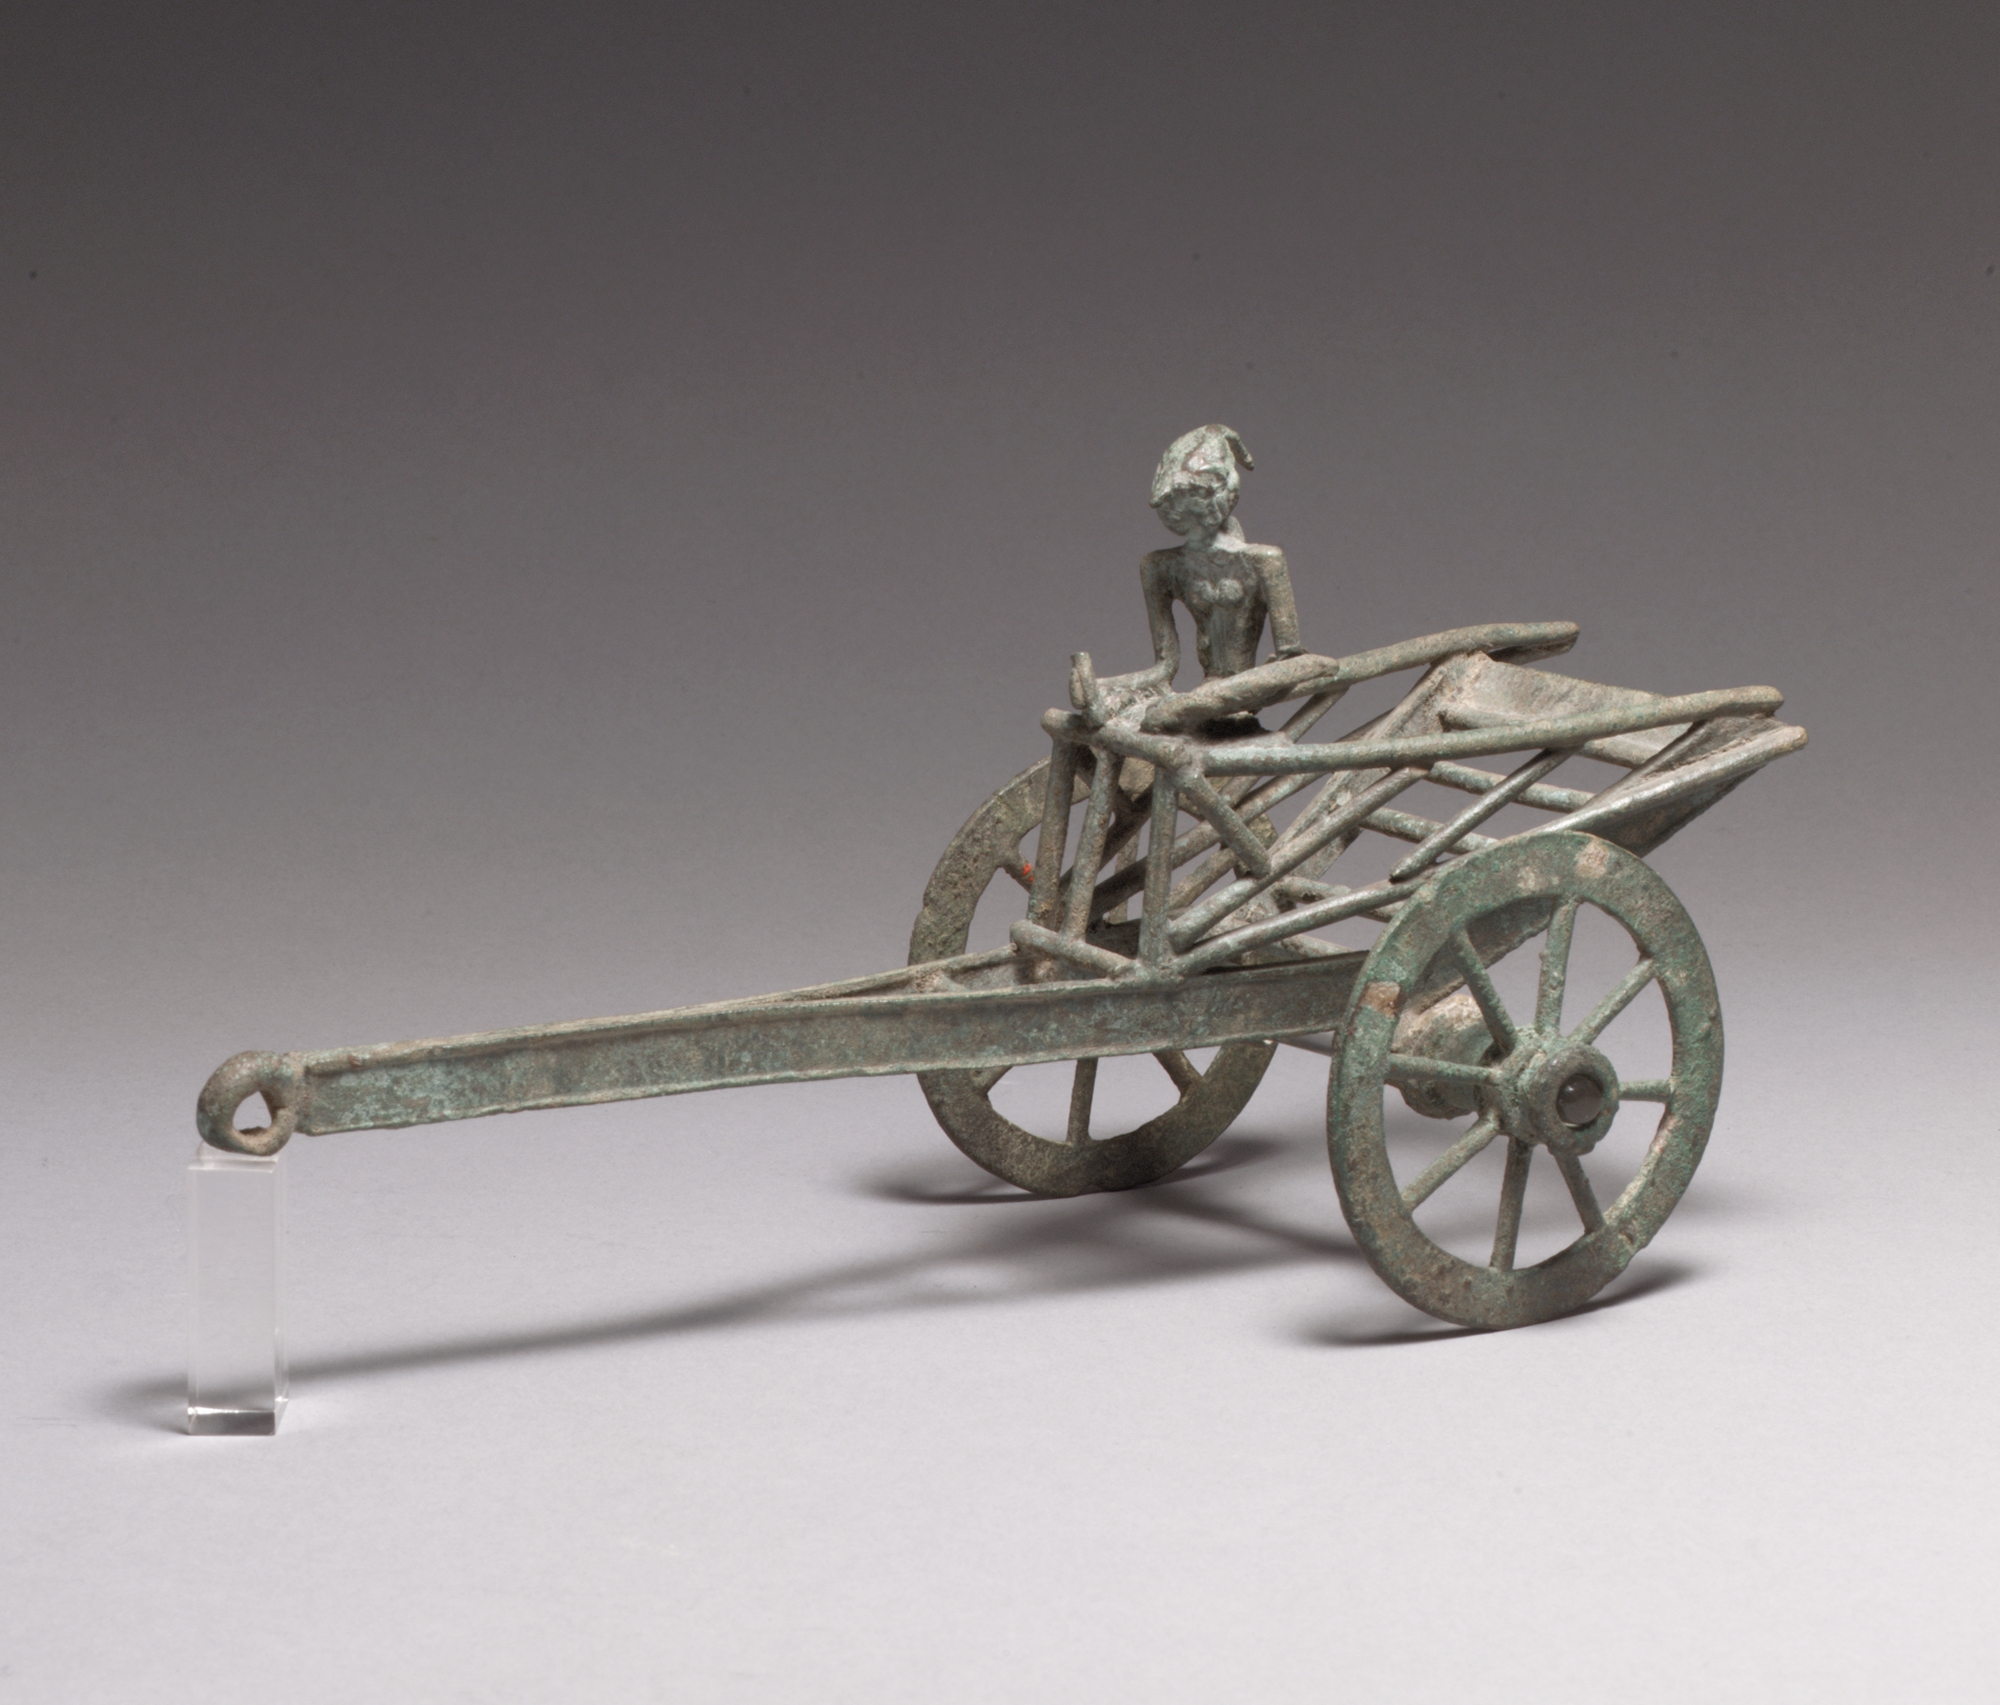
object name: figure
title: Pull Toy of a Cart and Driver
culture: indonesian, east java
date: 1401-1500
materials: bronze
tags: men,carts,toys